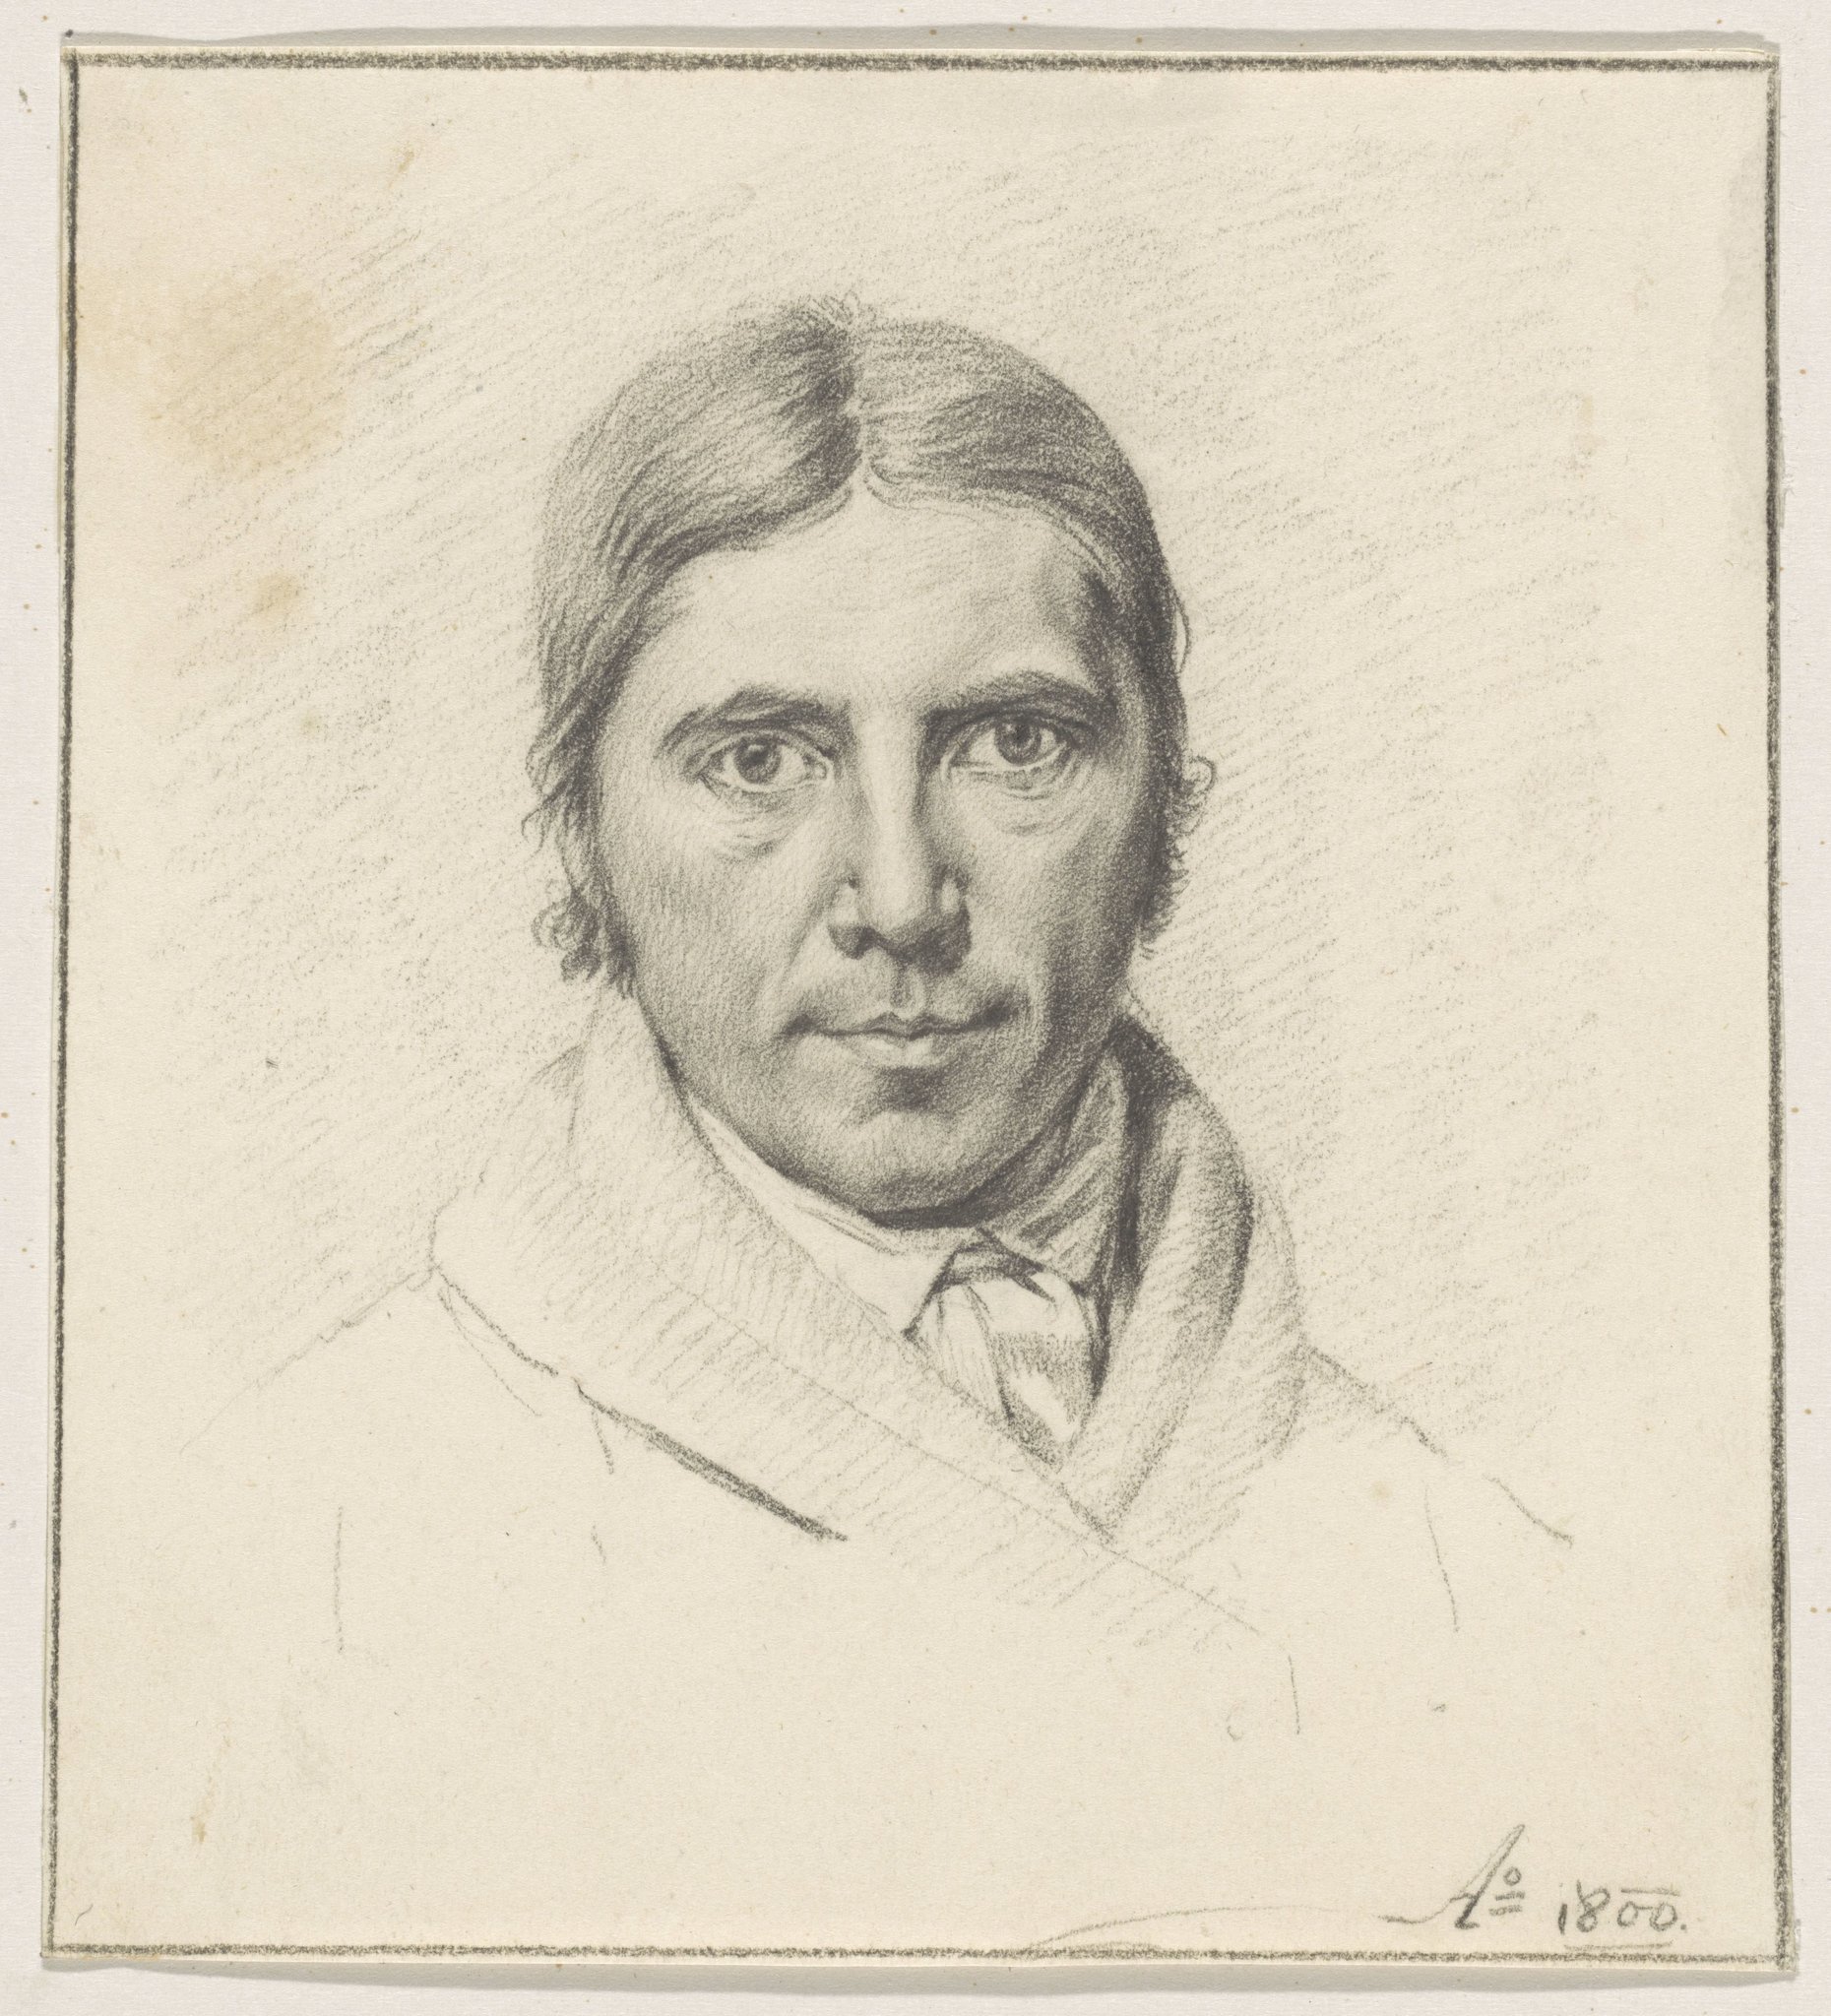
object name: drawing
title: Zelfportret van Taco Scheltema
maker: taco scheltema (i)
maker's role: draughtsman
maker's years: 1760-1837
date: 1800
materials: chalk, paper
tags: harlingen, draughtsman, taco scheltema (i), historical persons, portrait, self-portrait of artist